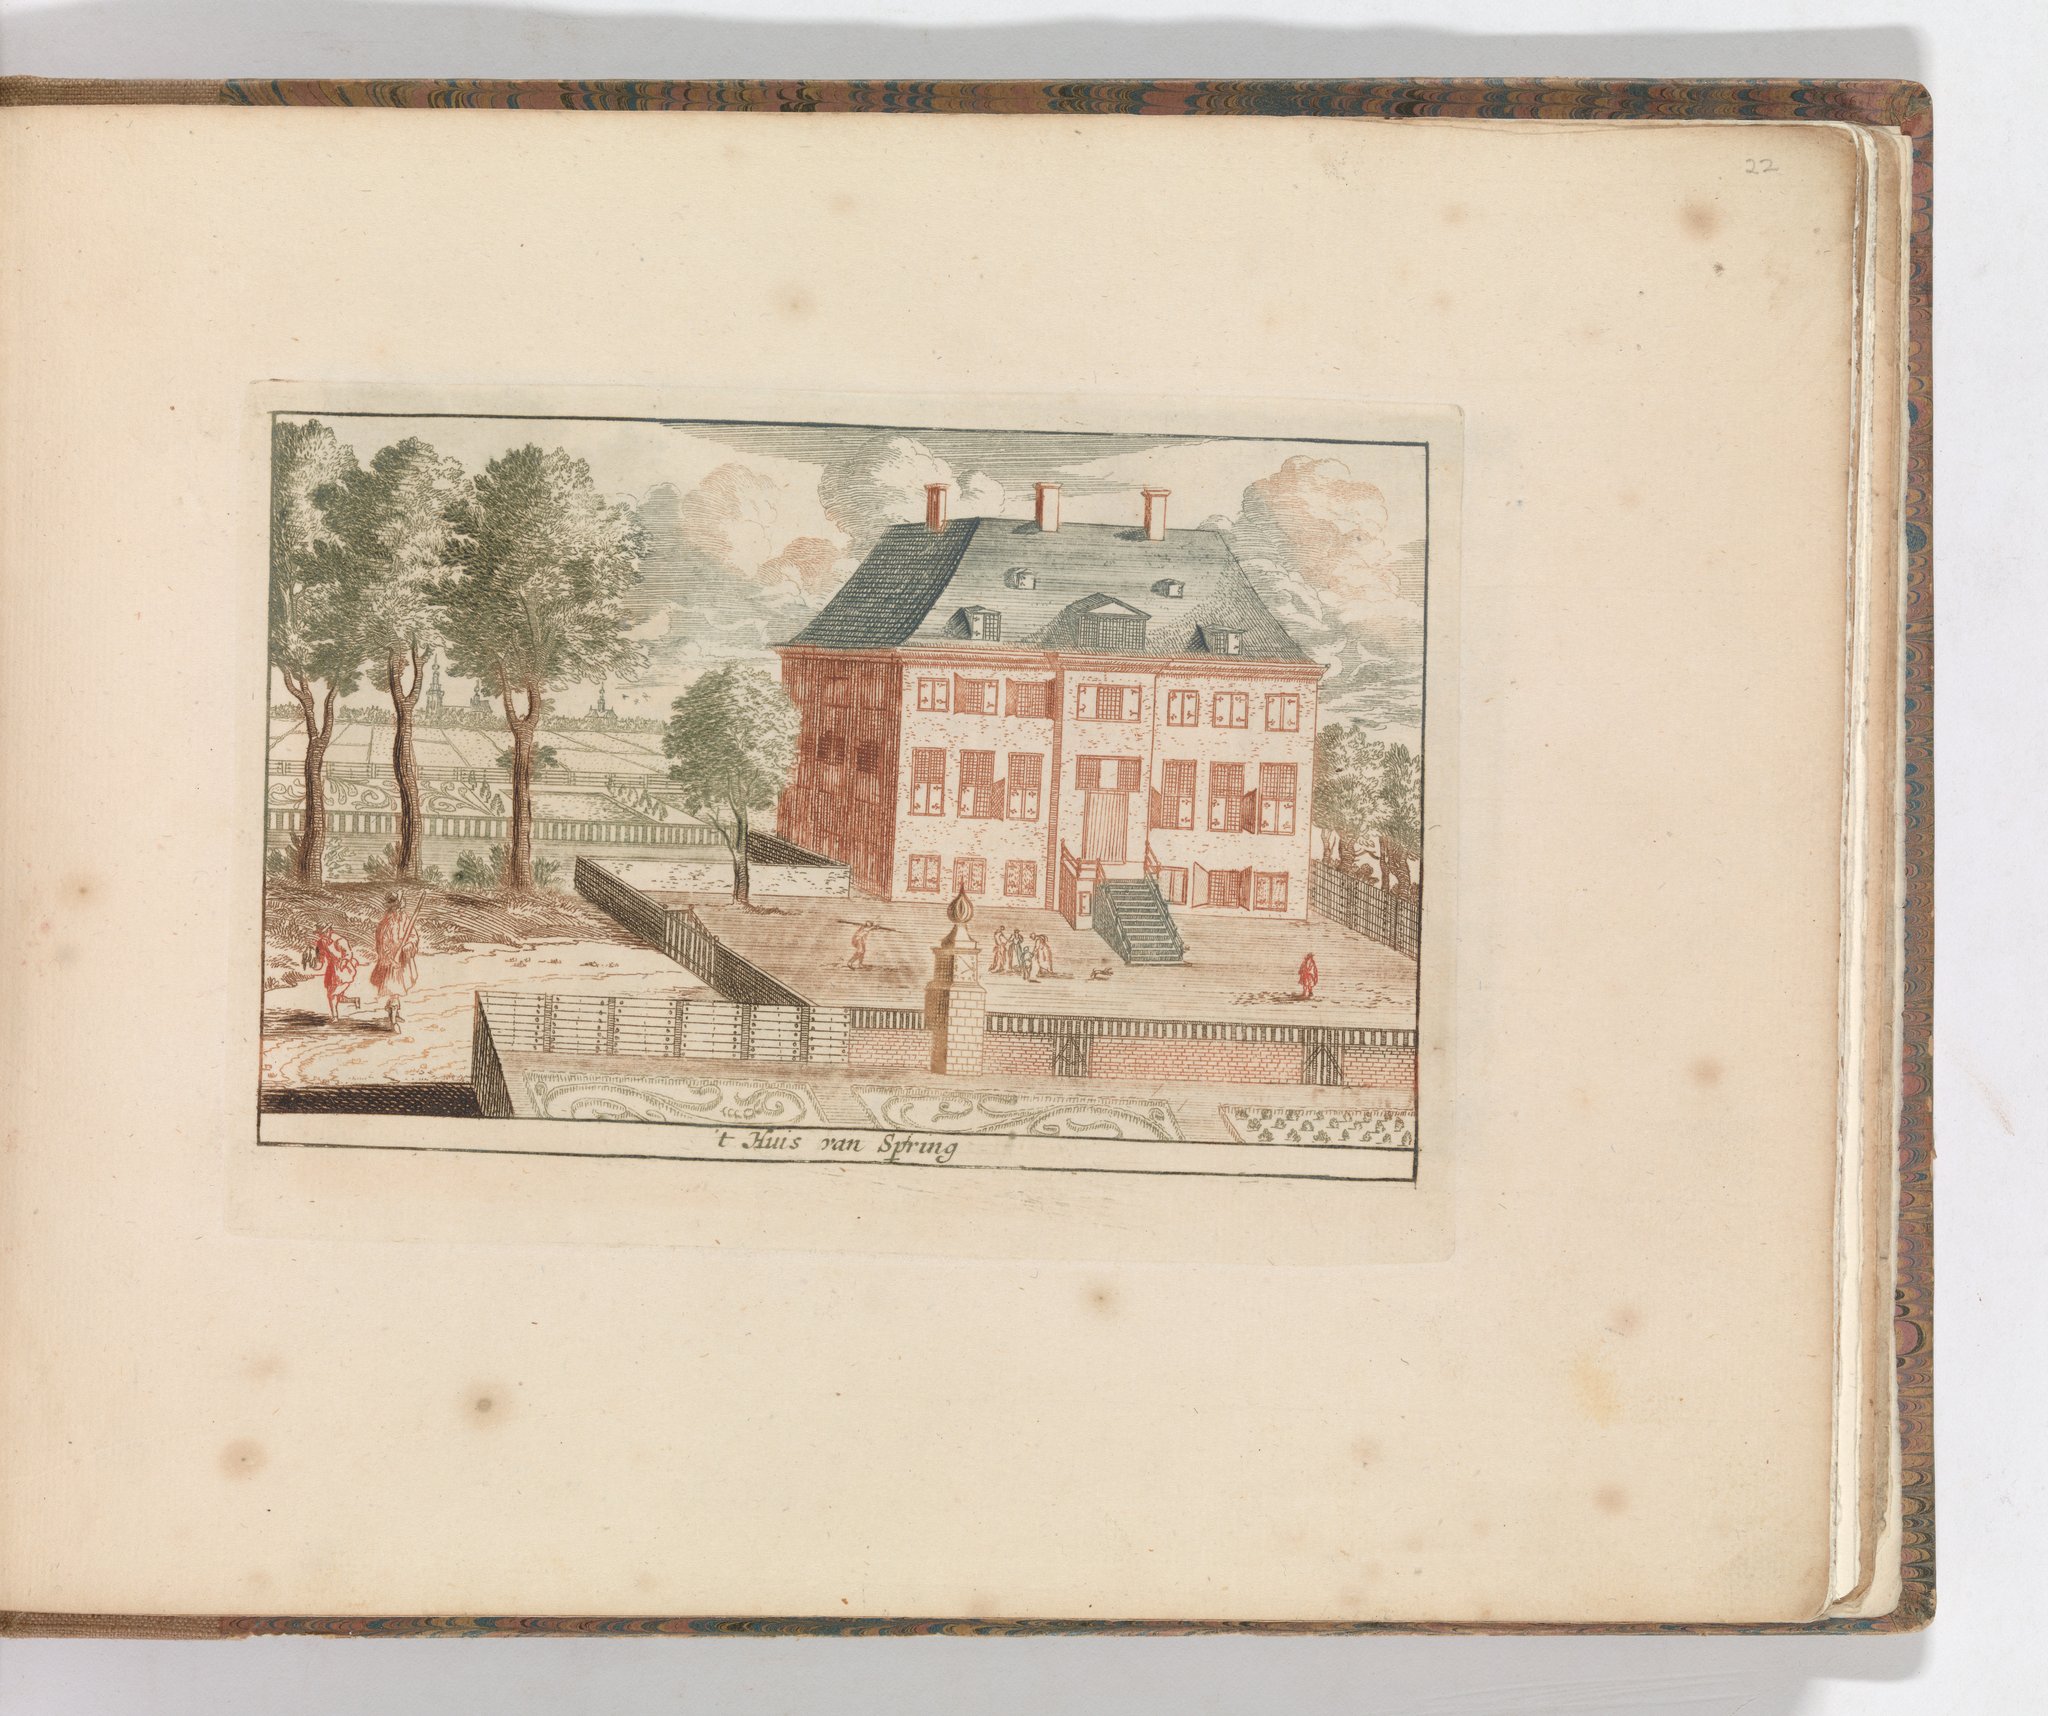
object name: book print ornament architecture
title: ' 't Huis van Spiring', in: Tooneel Der Voornaamste Nederlands Huizen, En Lust Hoven, Naar T Leven Afgebeeld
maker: carel allard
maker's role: publisher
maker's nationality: dutch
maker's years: 1648-1709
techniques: engraving, lithography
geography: amsterdam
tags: human figures,buildings